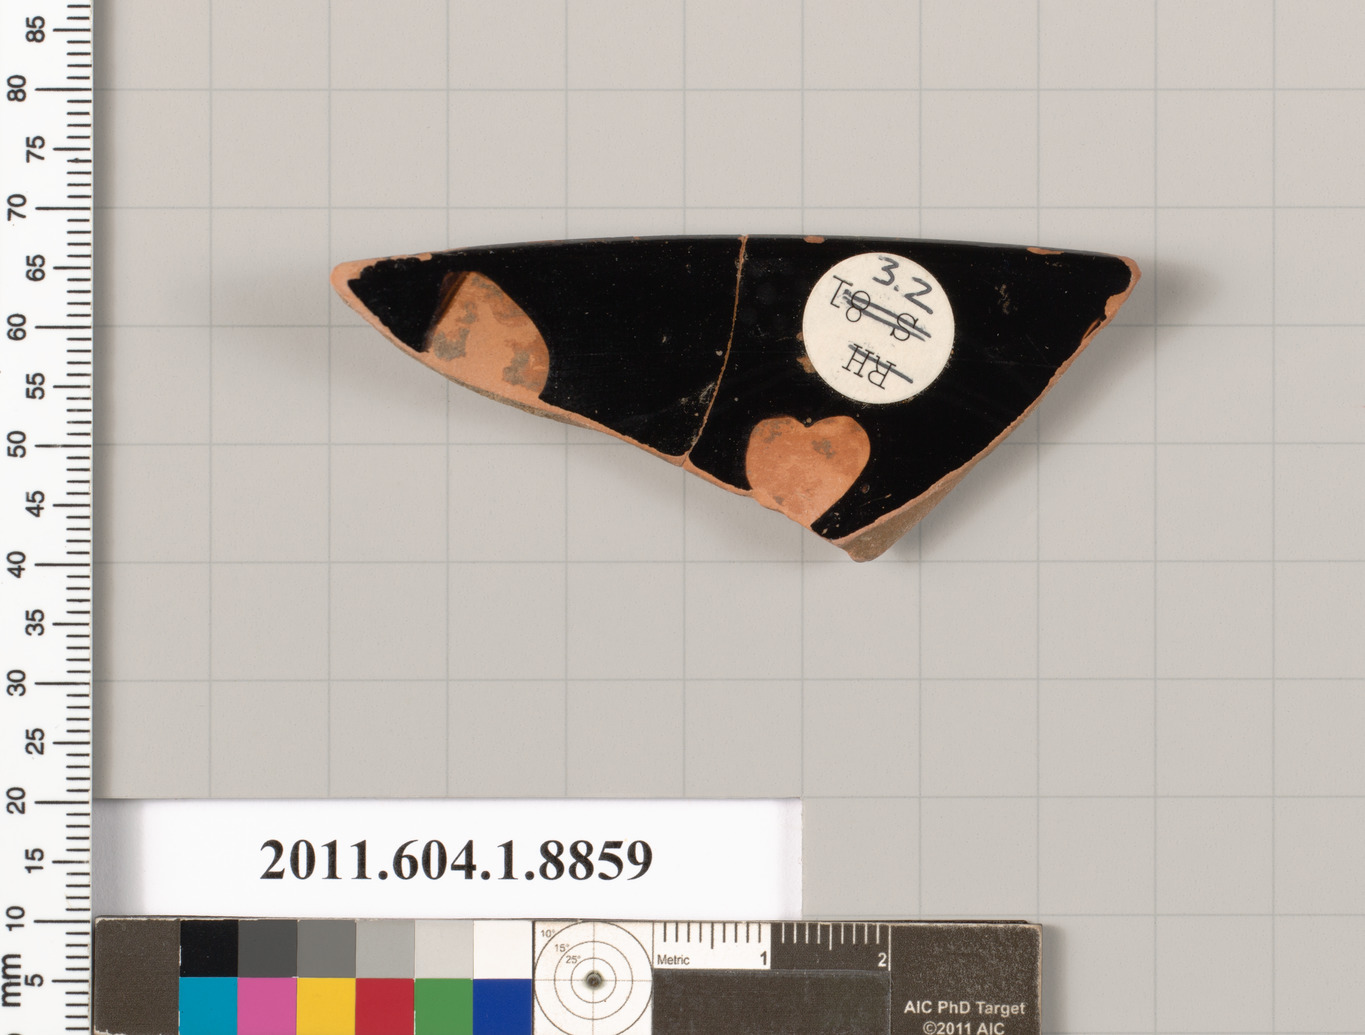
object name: kylix fragment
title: Terracotta fragment of a kylix (drinking cup)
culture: greek, attic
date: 467-435 BCE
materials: terracotta